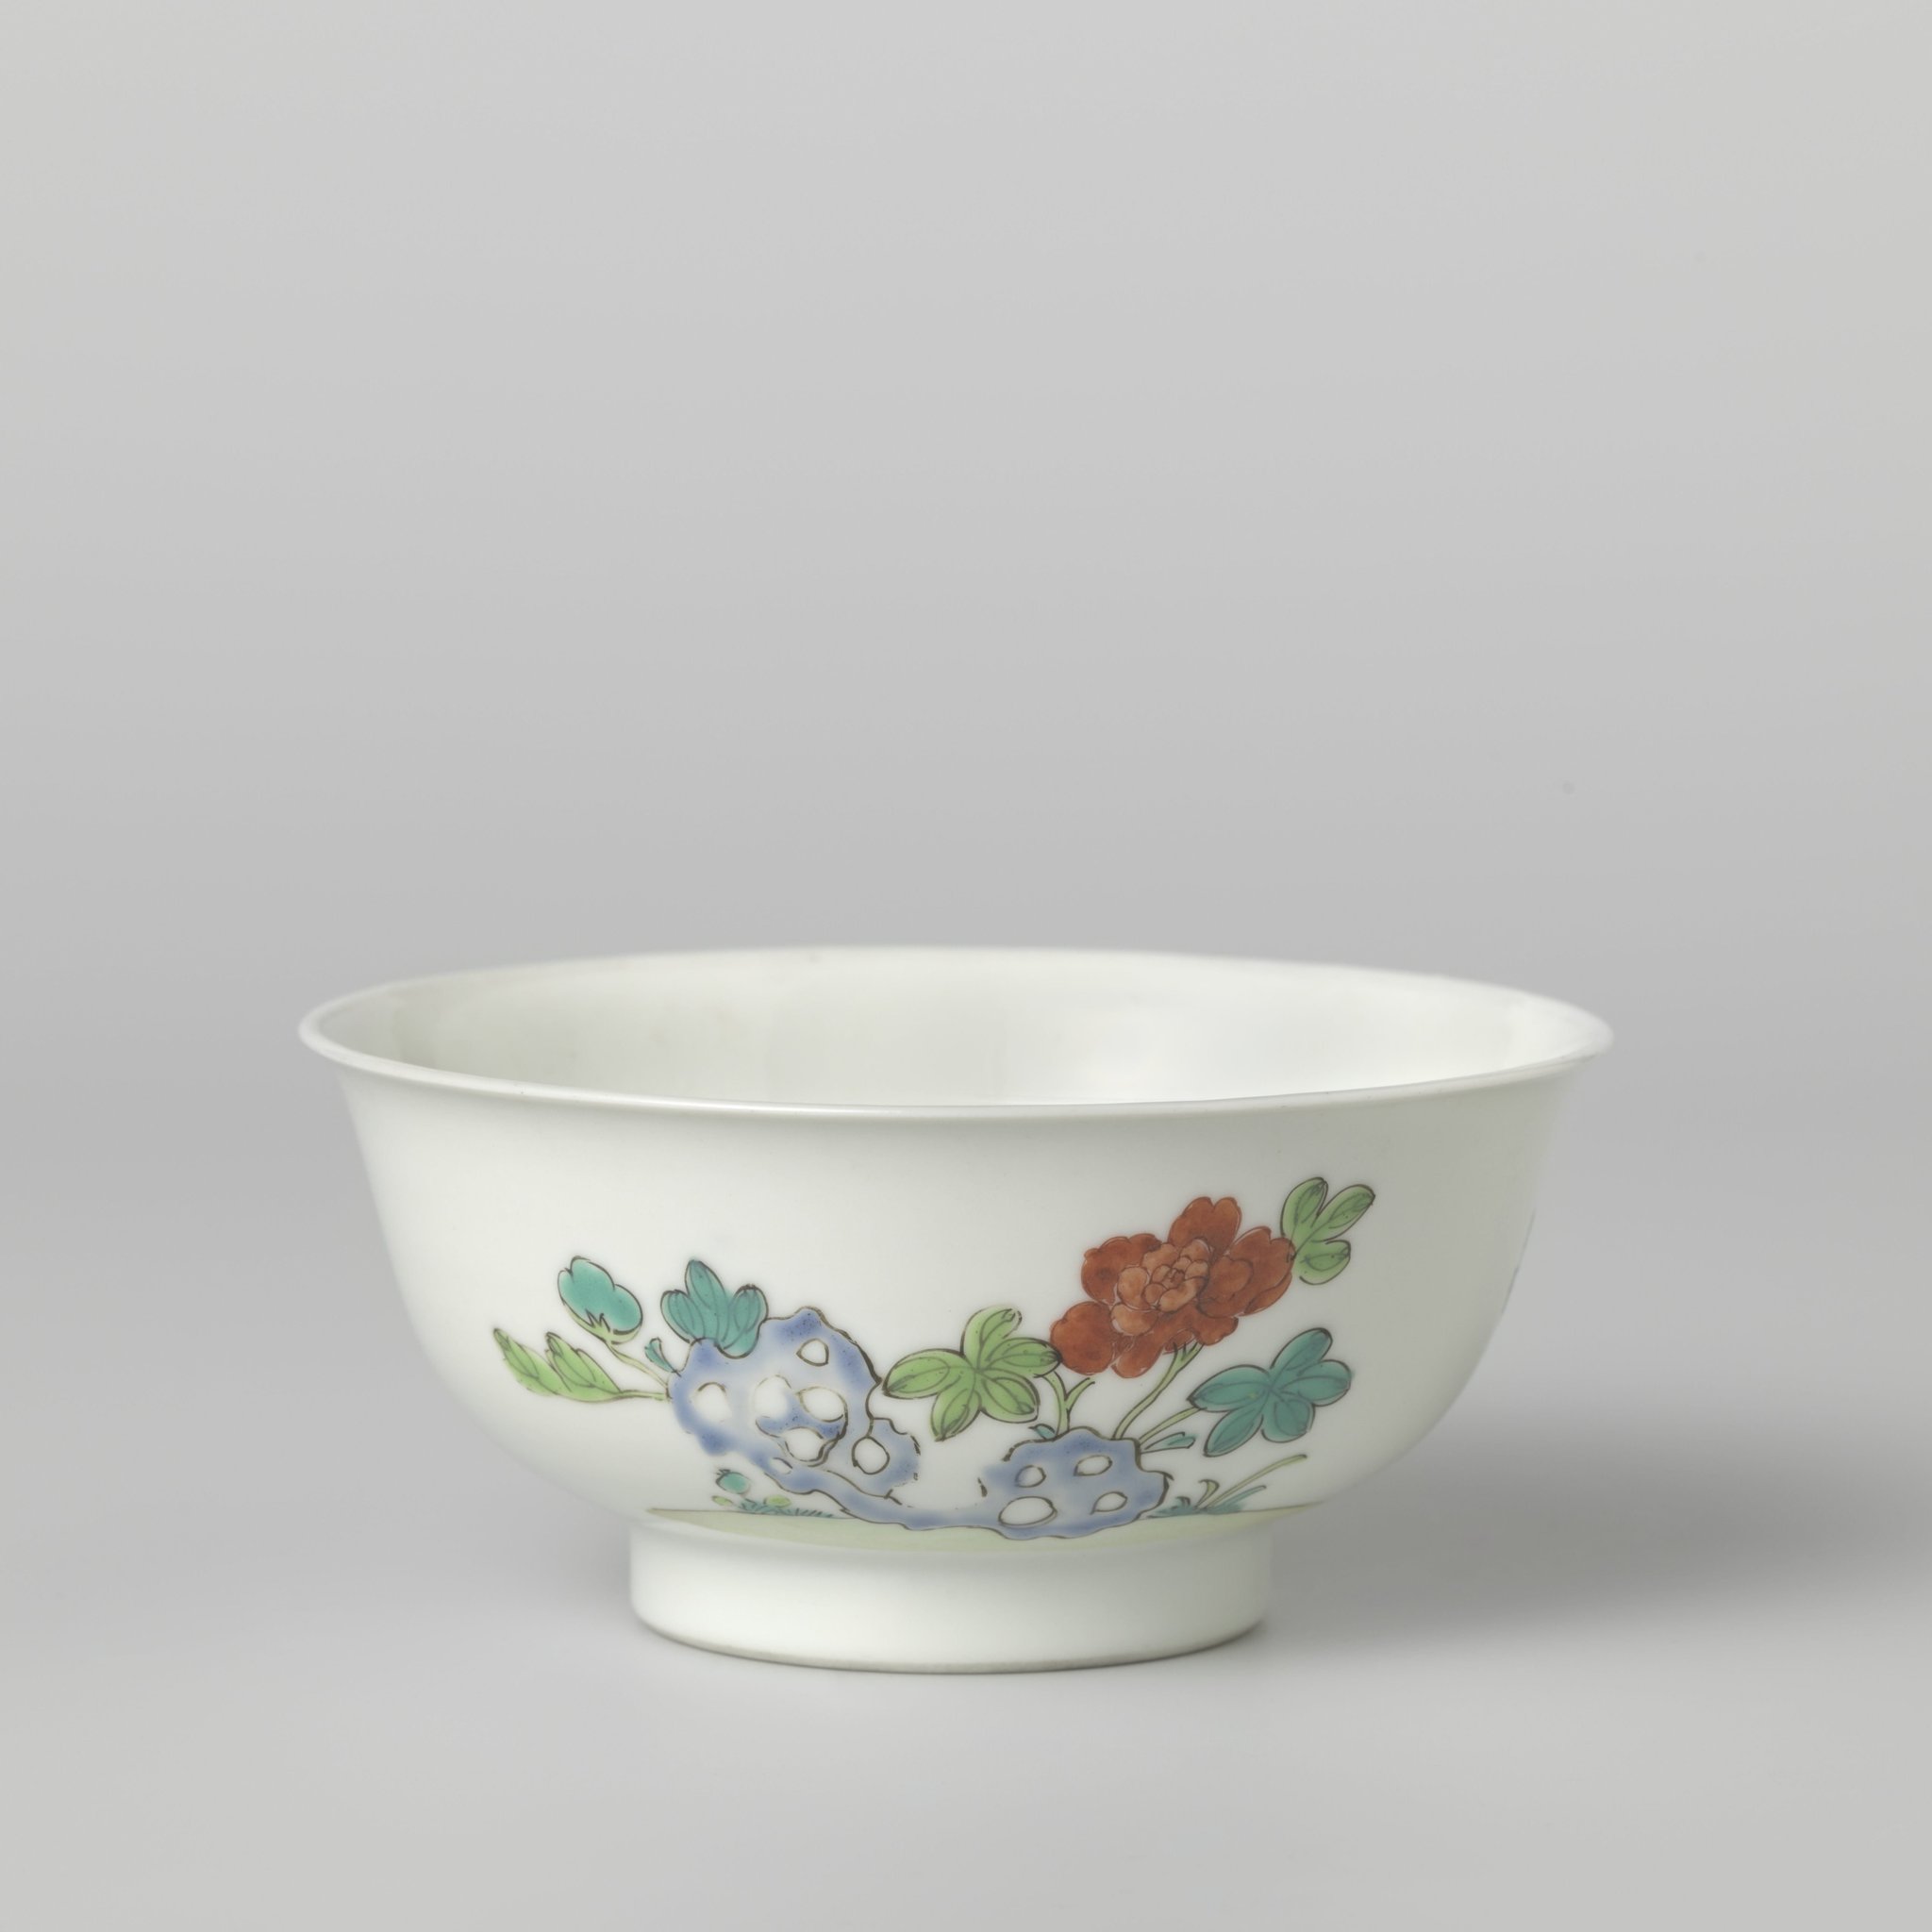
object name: bowl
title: Bell-shaped bowl with flower sprays and a flowering plant near a rock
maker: Anonymous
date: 1800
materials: glaze, gold, paint, porcelain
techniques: firing, gilding, turning, vitrification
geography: china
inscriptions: mark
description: Klokvormige kom van porselein, beschilderd in onderglazuur blauw en op het glazuur blauw, rood, groen, geel, zwart en goud. Op de buitenwand aan de ene kant een chrysanttak en een bamboetak, de andere kant met een bloeiende pioenplant bij een rots. Gemerkt op de onderzijde met een zegelmerk in een dubbele cirkel. Famille verte.